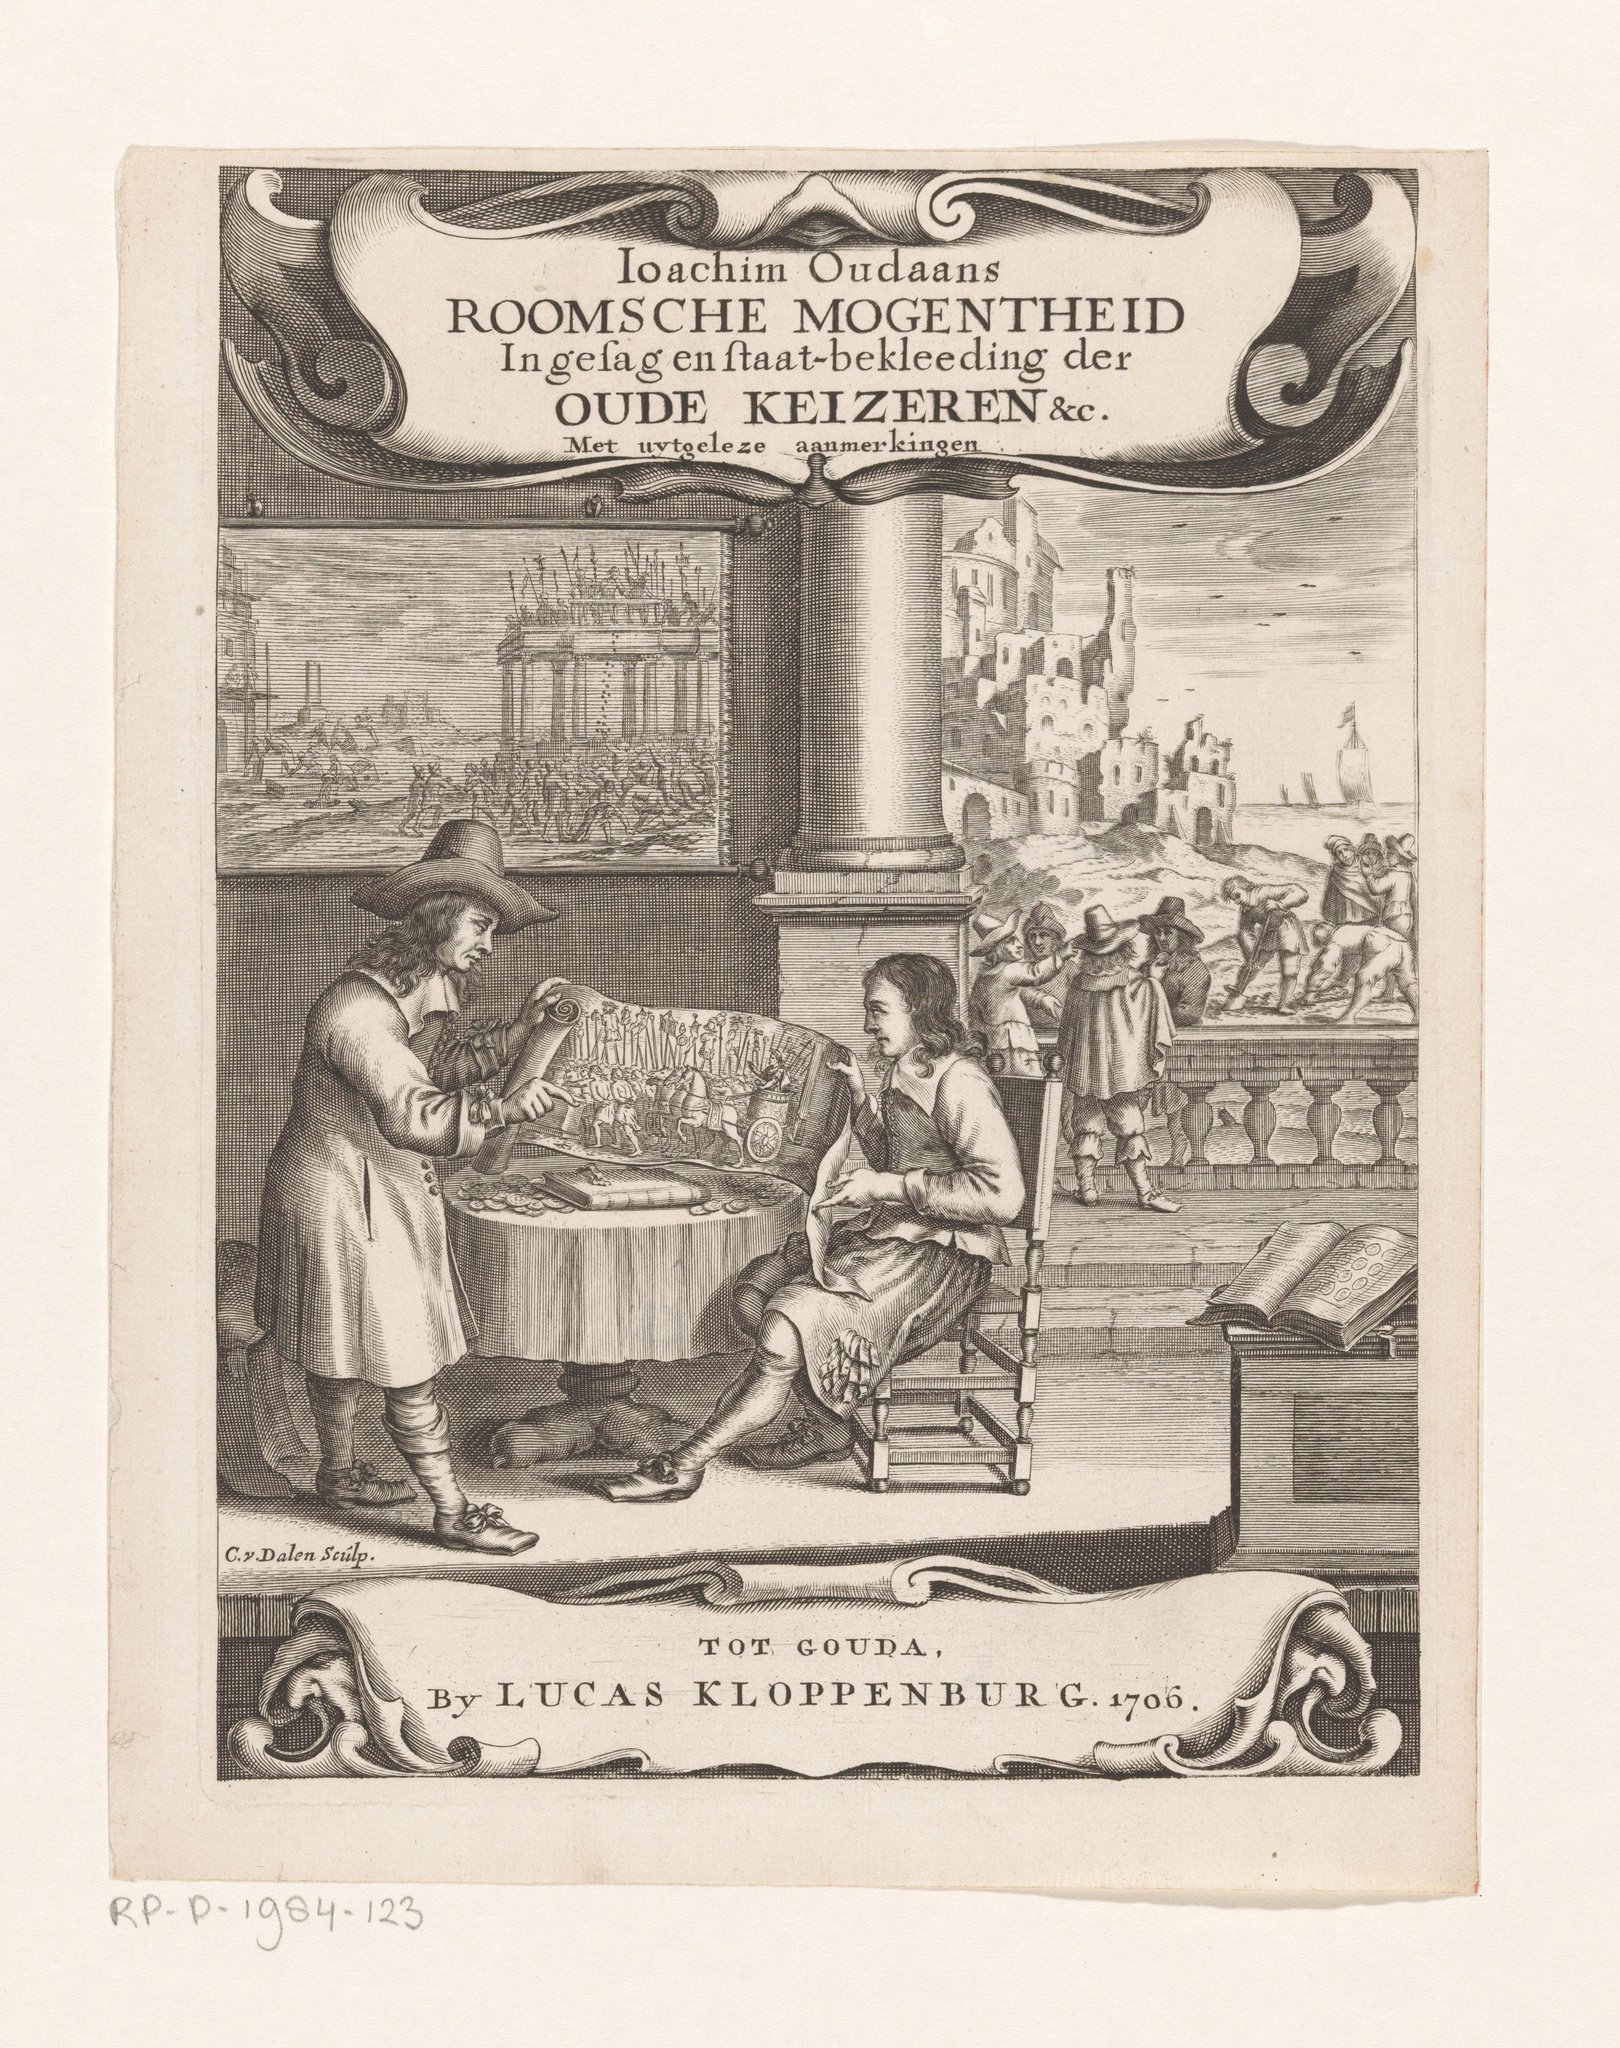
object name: print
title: Twee mannen kijken naar prent met triomftocht van Romeinse keizer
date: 1706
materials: paper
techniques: engraving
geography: gouda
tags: conqueror triumphing, triumphal entry of victor, single printed leaf: broadsheet, leaflet, digging for or finding of treasure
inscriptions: collector's mark: Lugt 2760, collector's mark: Lugt 2228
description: Twee mannen kijken naar een prent met triomftocht van een Romeinse keizer. Op tafel liggen munten, rechts toont een opengeslagen boek afbeeldingen van munten. Op de achtergrond graven mannen in de buurt van ruïnes.